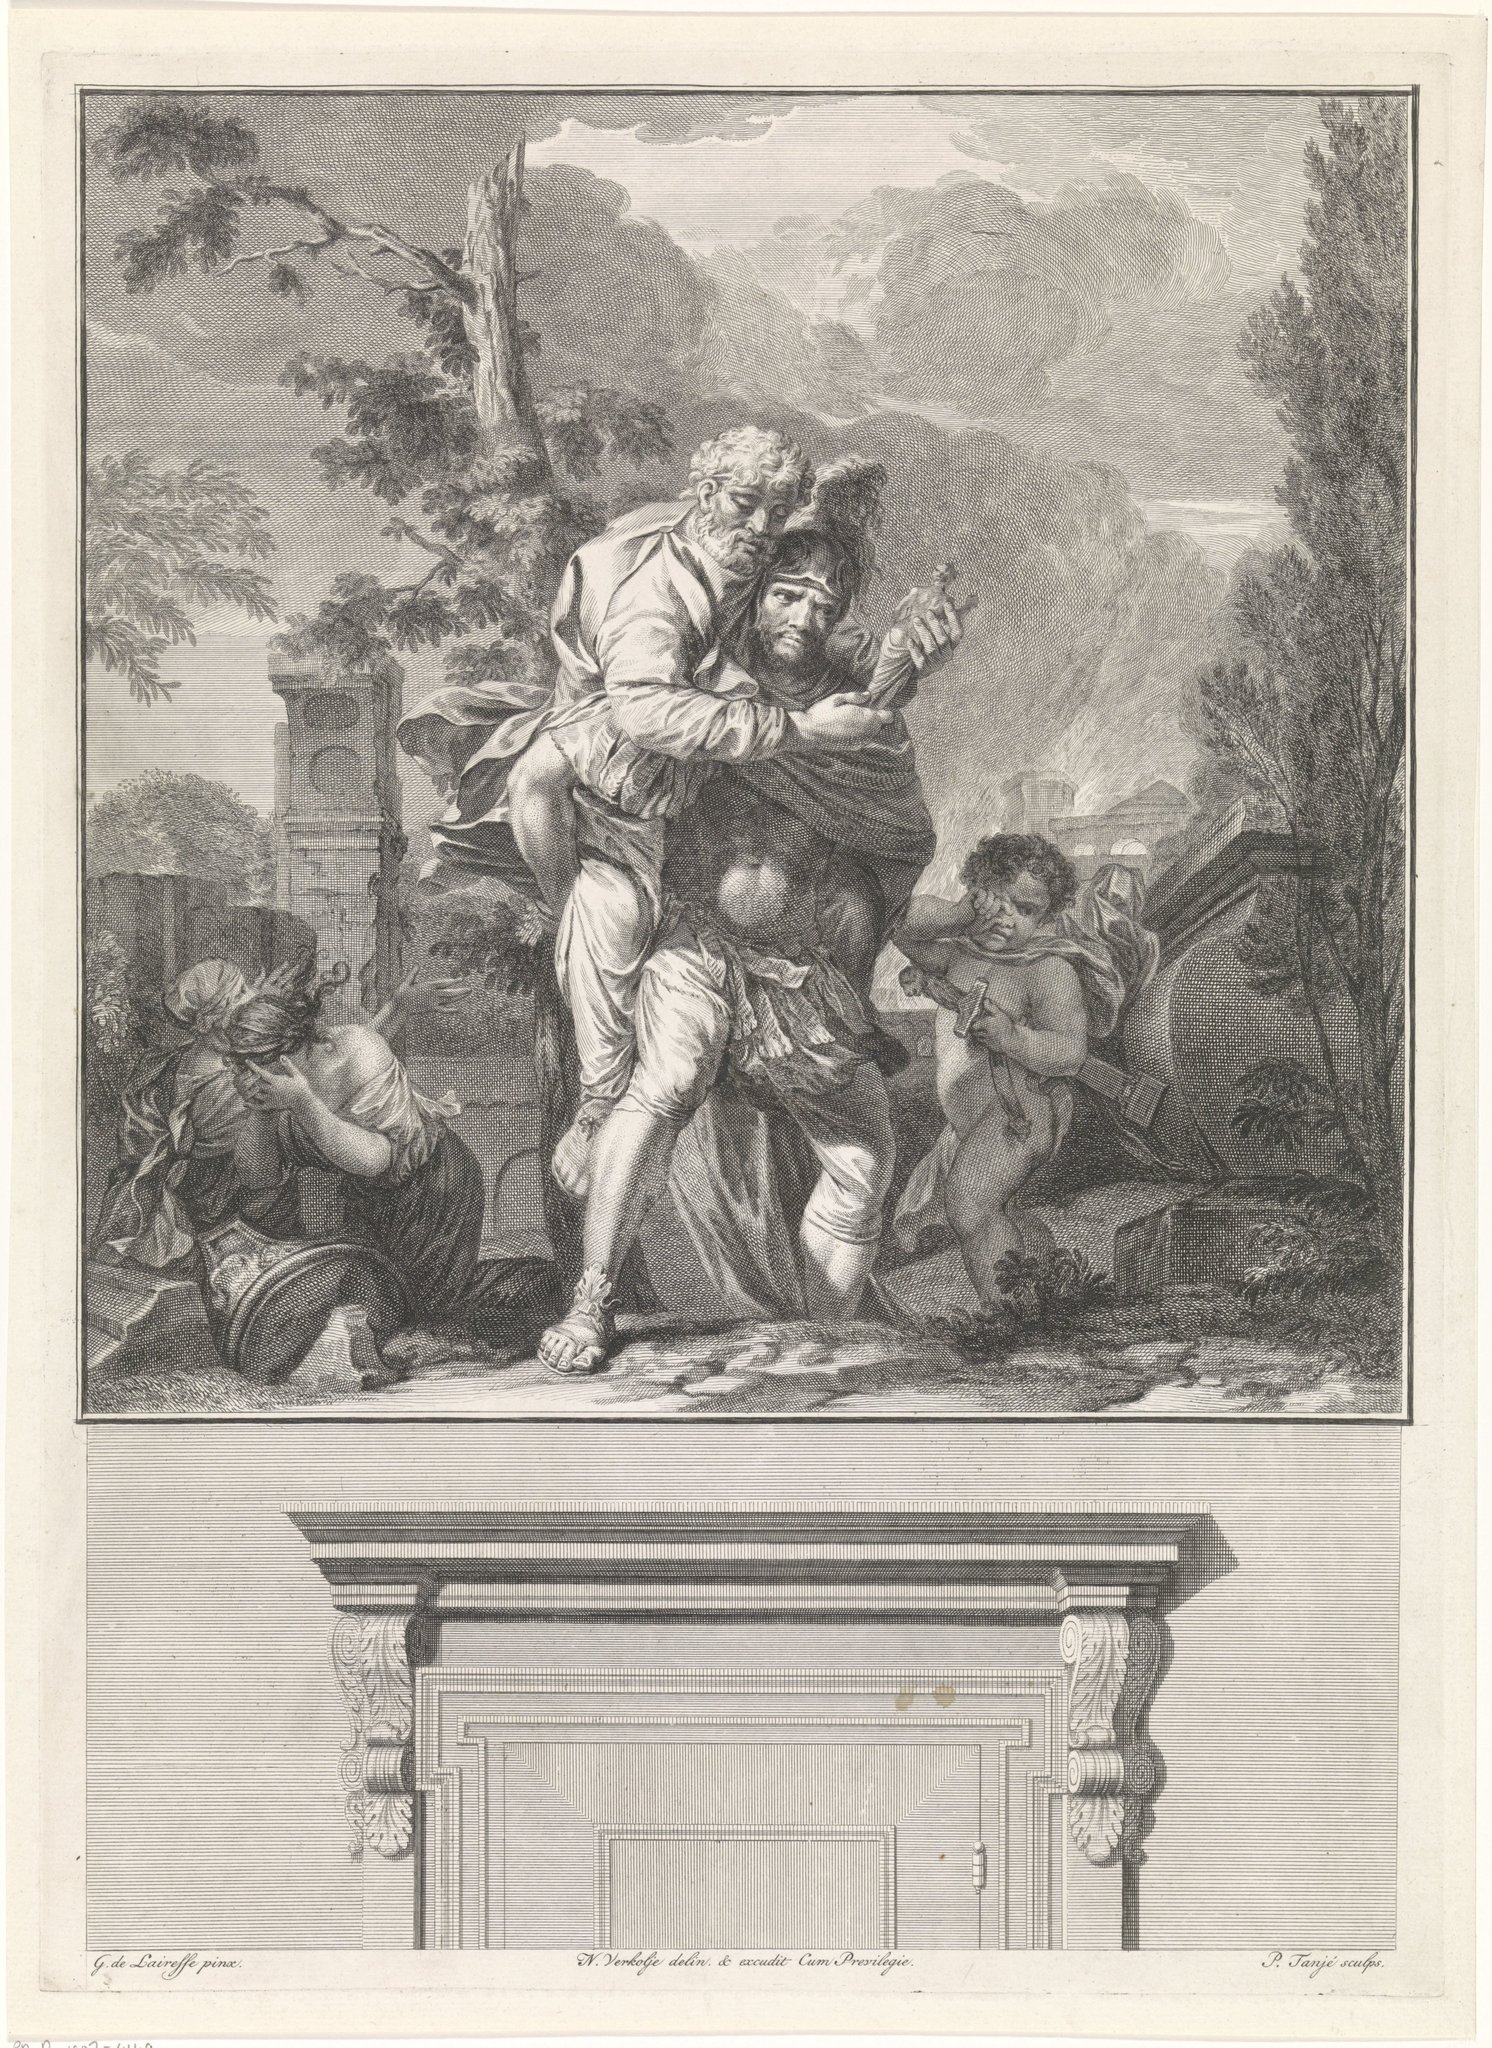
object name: print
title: Tafereelen, (...) in de raadkamer van den hove van justitie van Holland, Zeeland, en Westvriesland (...)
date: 1737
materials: paper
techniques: engraving, etching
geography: amsterdam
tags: 'pius aeneas': aeneas, leading ascanius, escapes from burning troy, carrying his father anchises with the penates; his wife creusa, who sets out with them, is lost on the way, closed door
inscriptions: collector's mark: Lugt 2228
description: Aeneas ontvlucht het brandende Troje met zijn oude vader Anchises op zijn rug. Naast hem loopt zijn huilende zoontje. Links de vrouw van Aeneas met haar handen voor haar gezicht. Voorstelling boven de deur van de Raadkamer van het Hof van Justitie van Holland, Zeeland en West-Friesland in het Binnenhof te Den Haag.